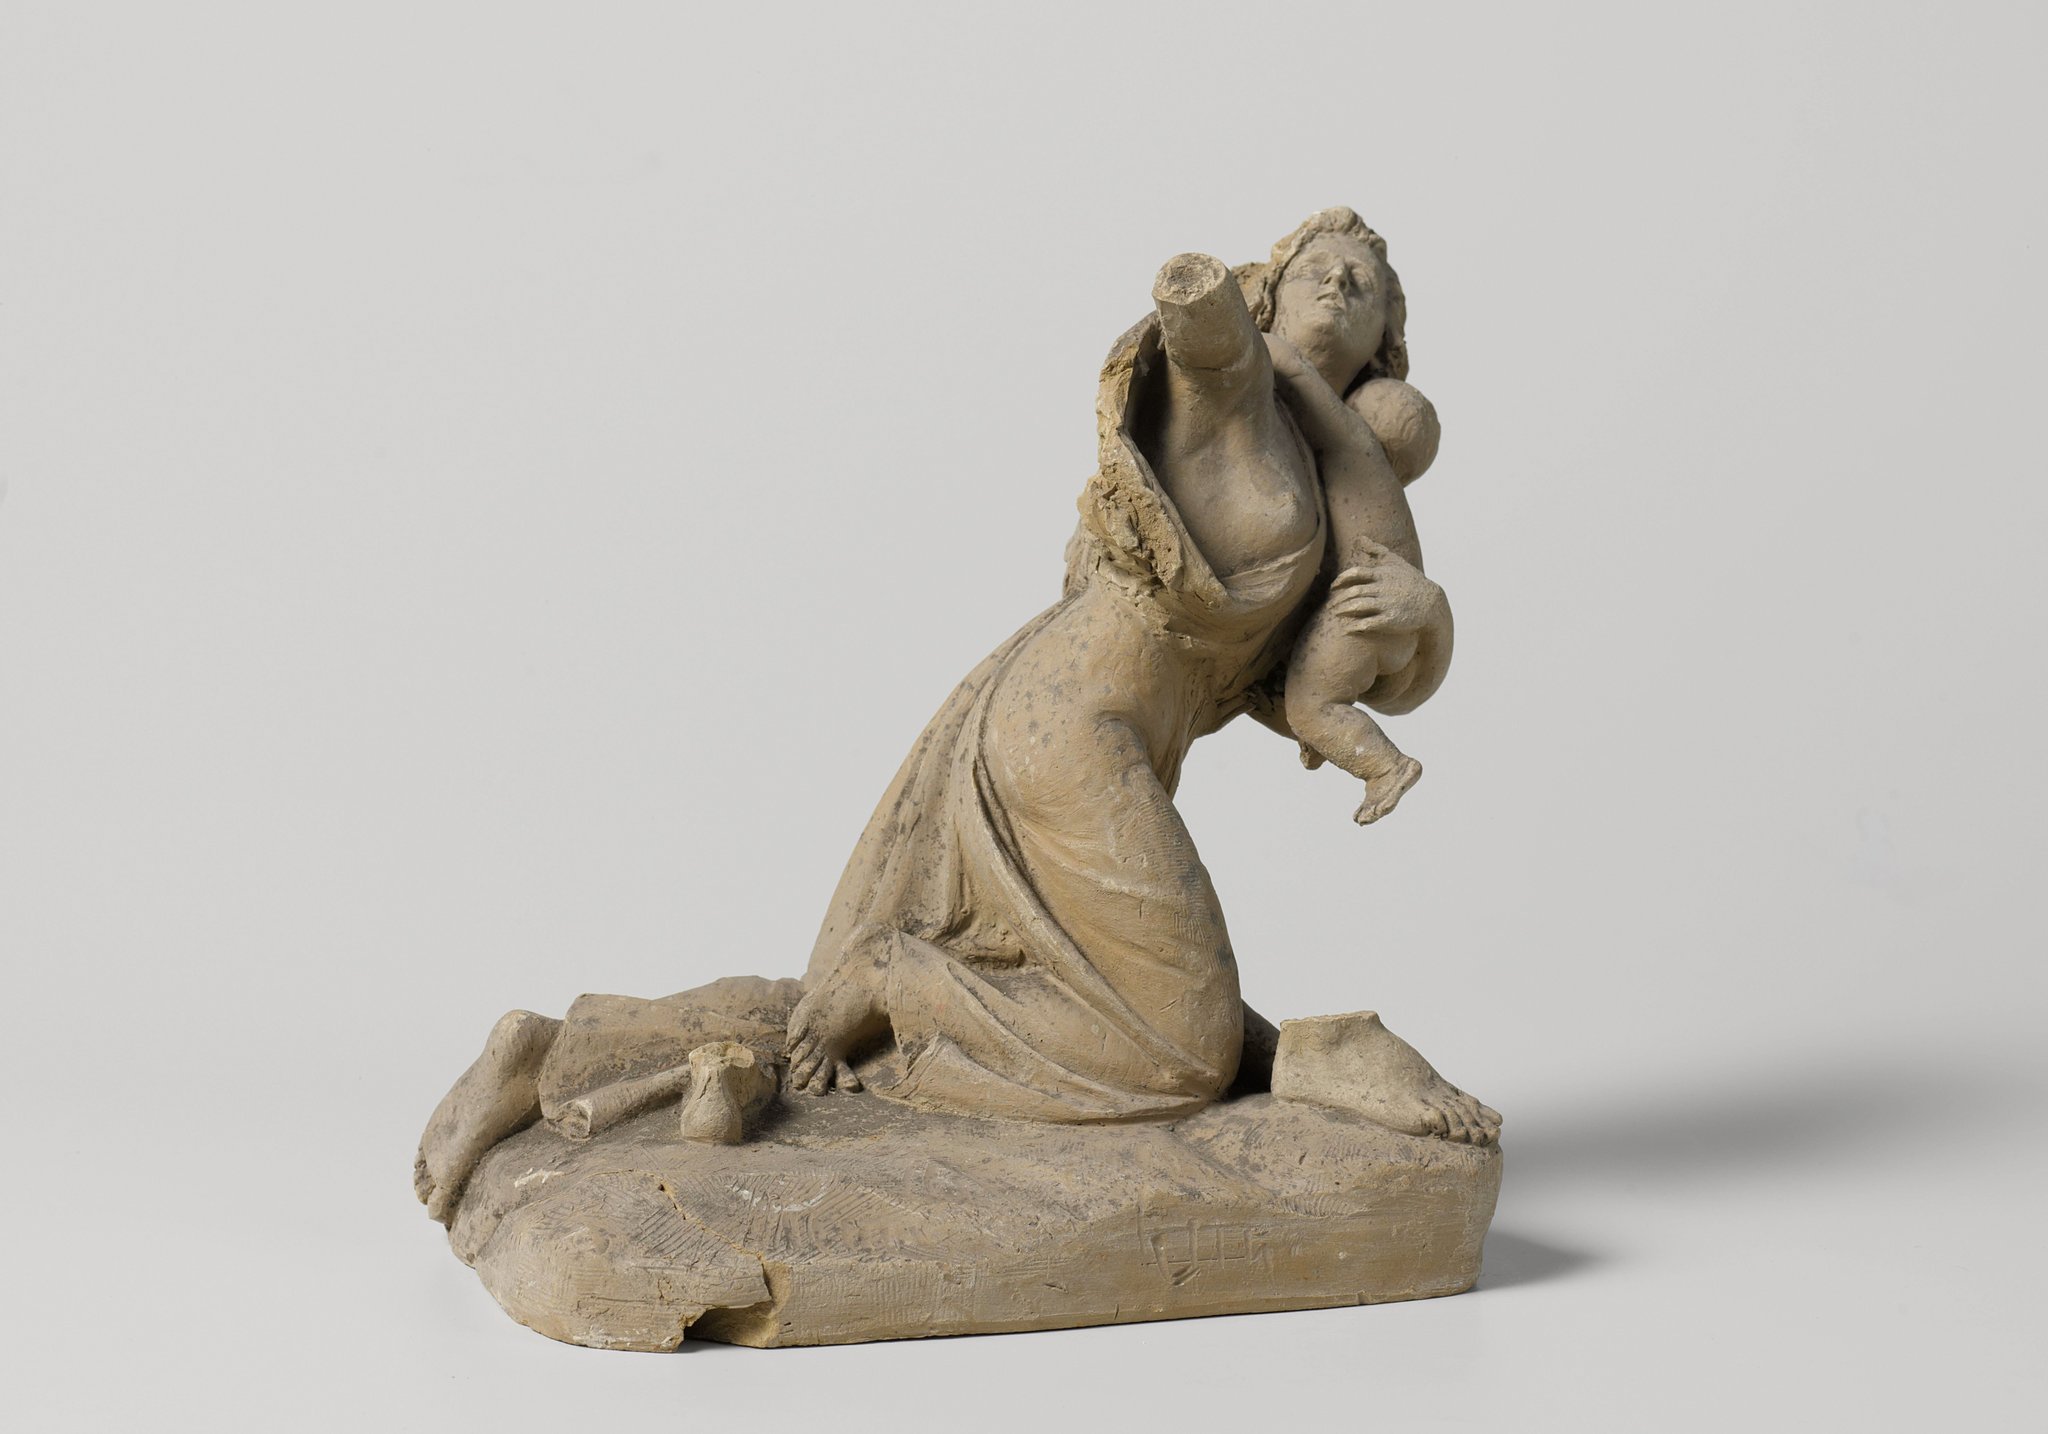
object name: sculpture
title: De kindermoord van Bethlehem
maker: eugène lacomblé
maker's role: draughtsman, painter, sculptor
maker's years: 1828-1905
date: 1868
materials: clay